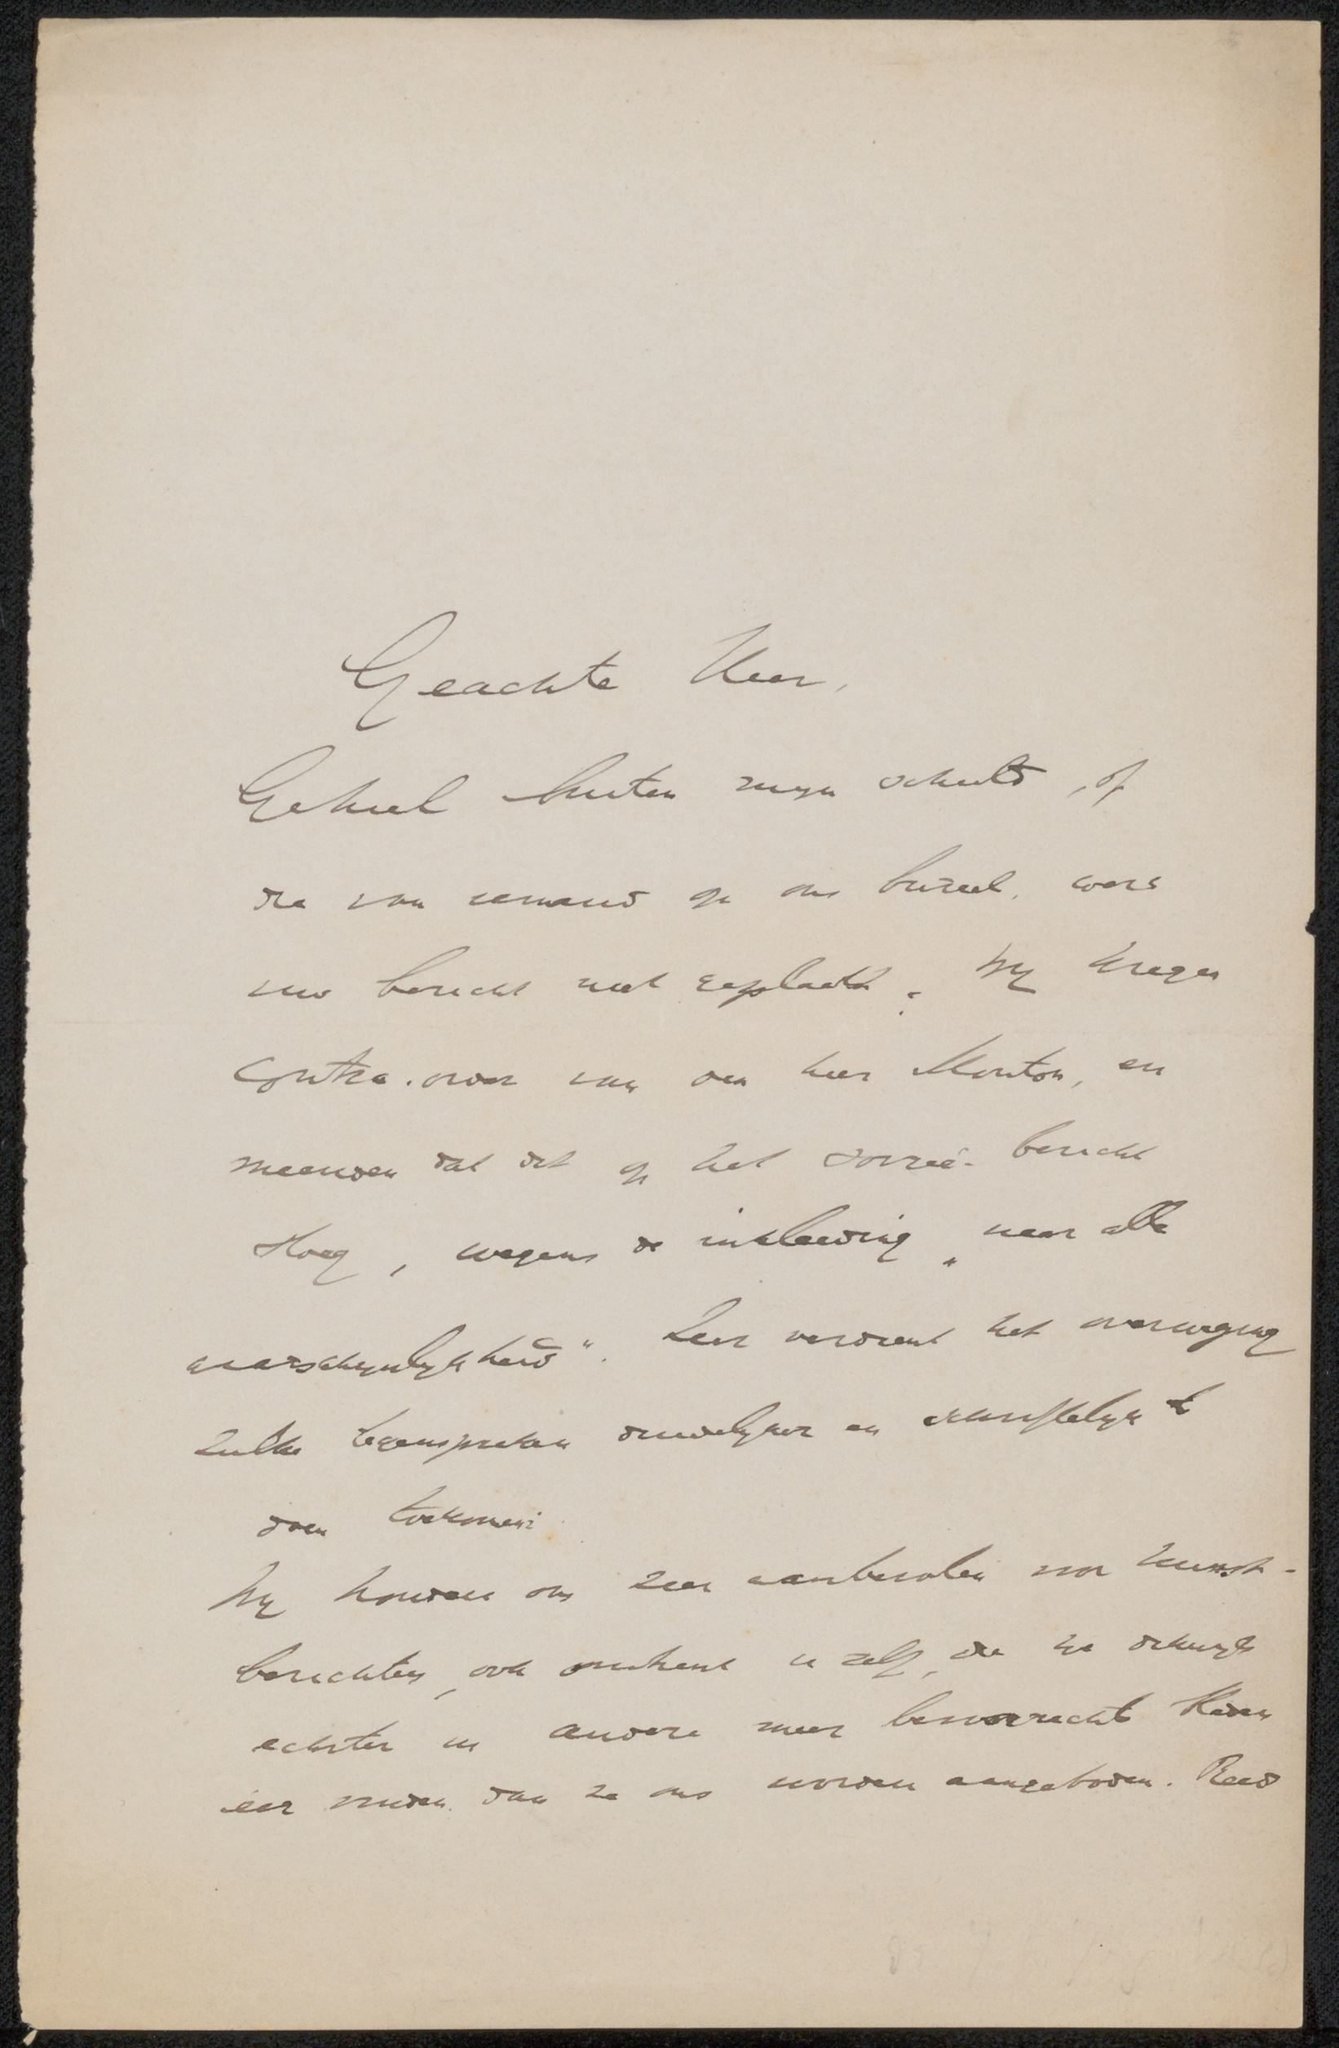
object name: letter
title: Brief aan Philip Zilcken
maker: j. de jong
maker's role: schrijver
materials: ink, paper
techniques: pen, writing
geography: the hague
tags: martinus mouton, the hague, draughtsman, philip zilcken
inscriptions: collector's mark: ‘RPK’